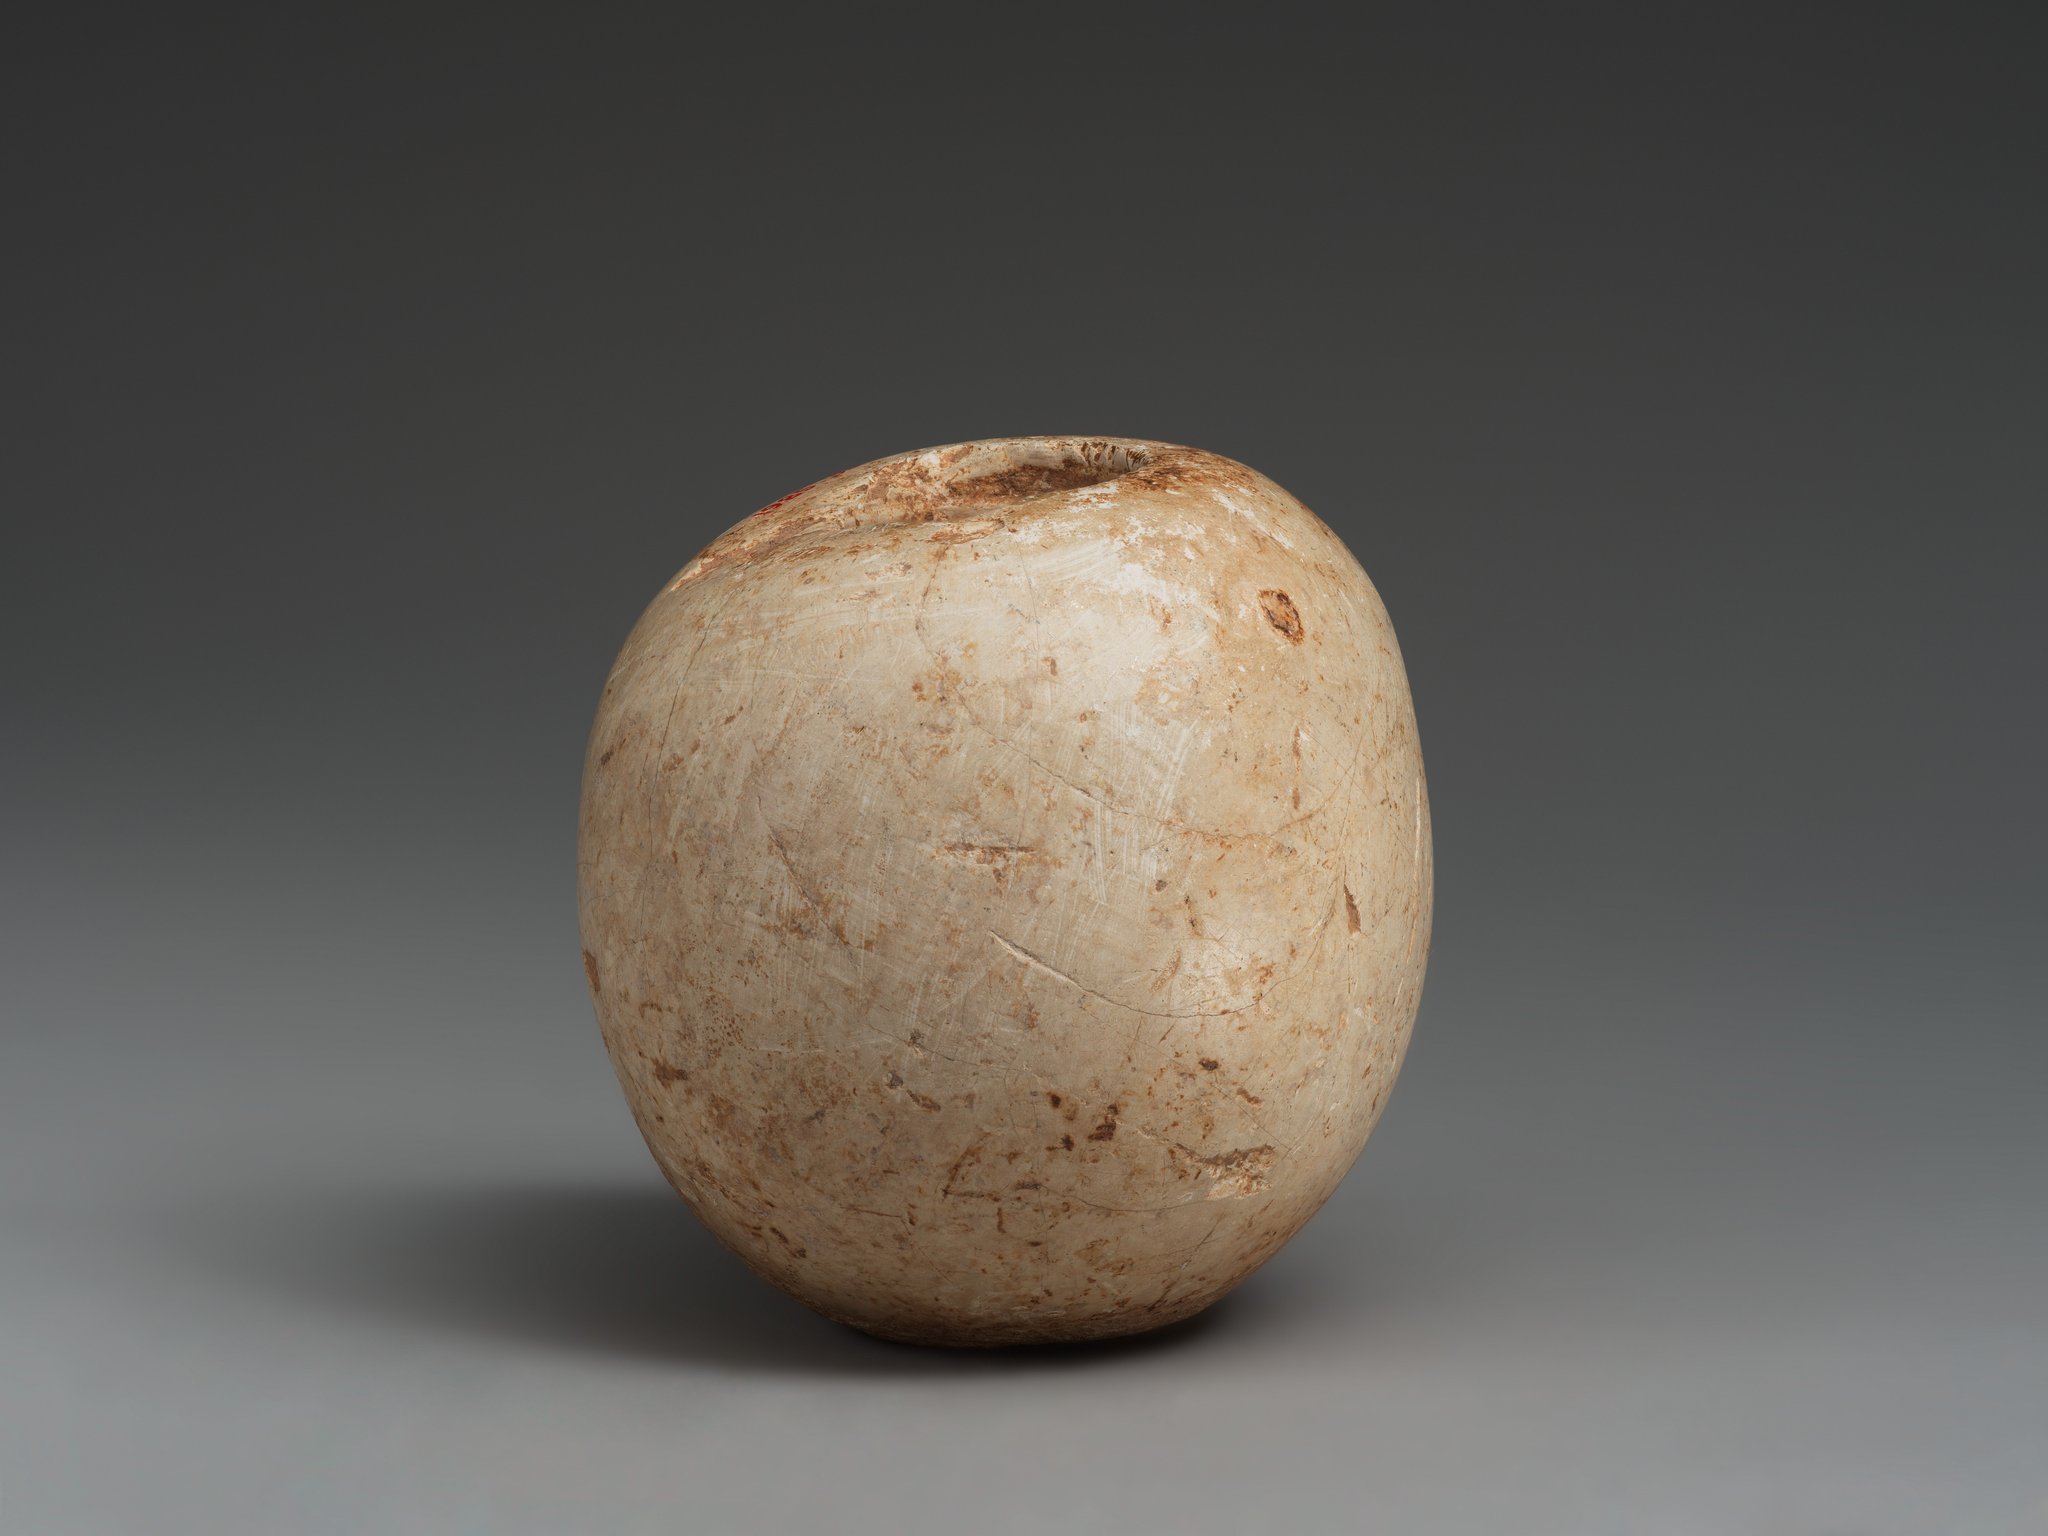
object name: mace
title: Mace head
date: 7000-5001 BCE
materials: stone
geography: syria